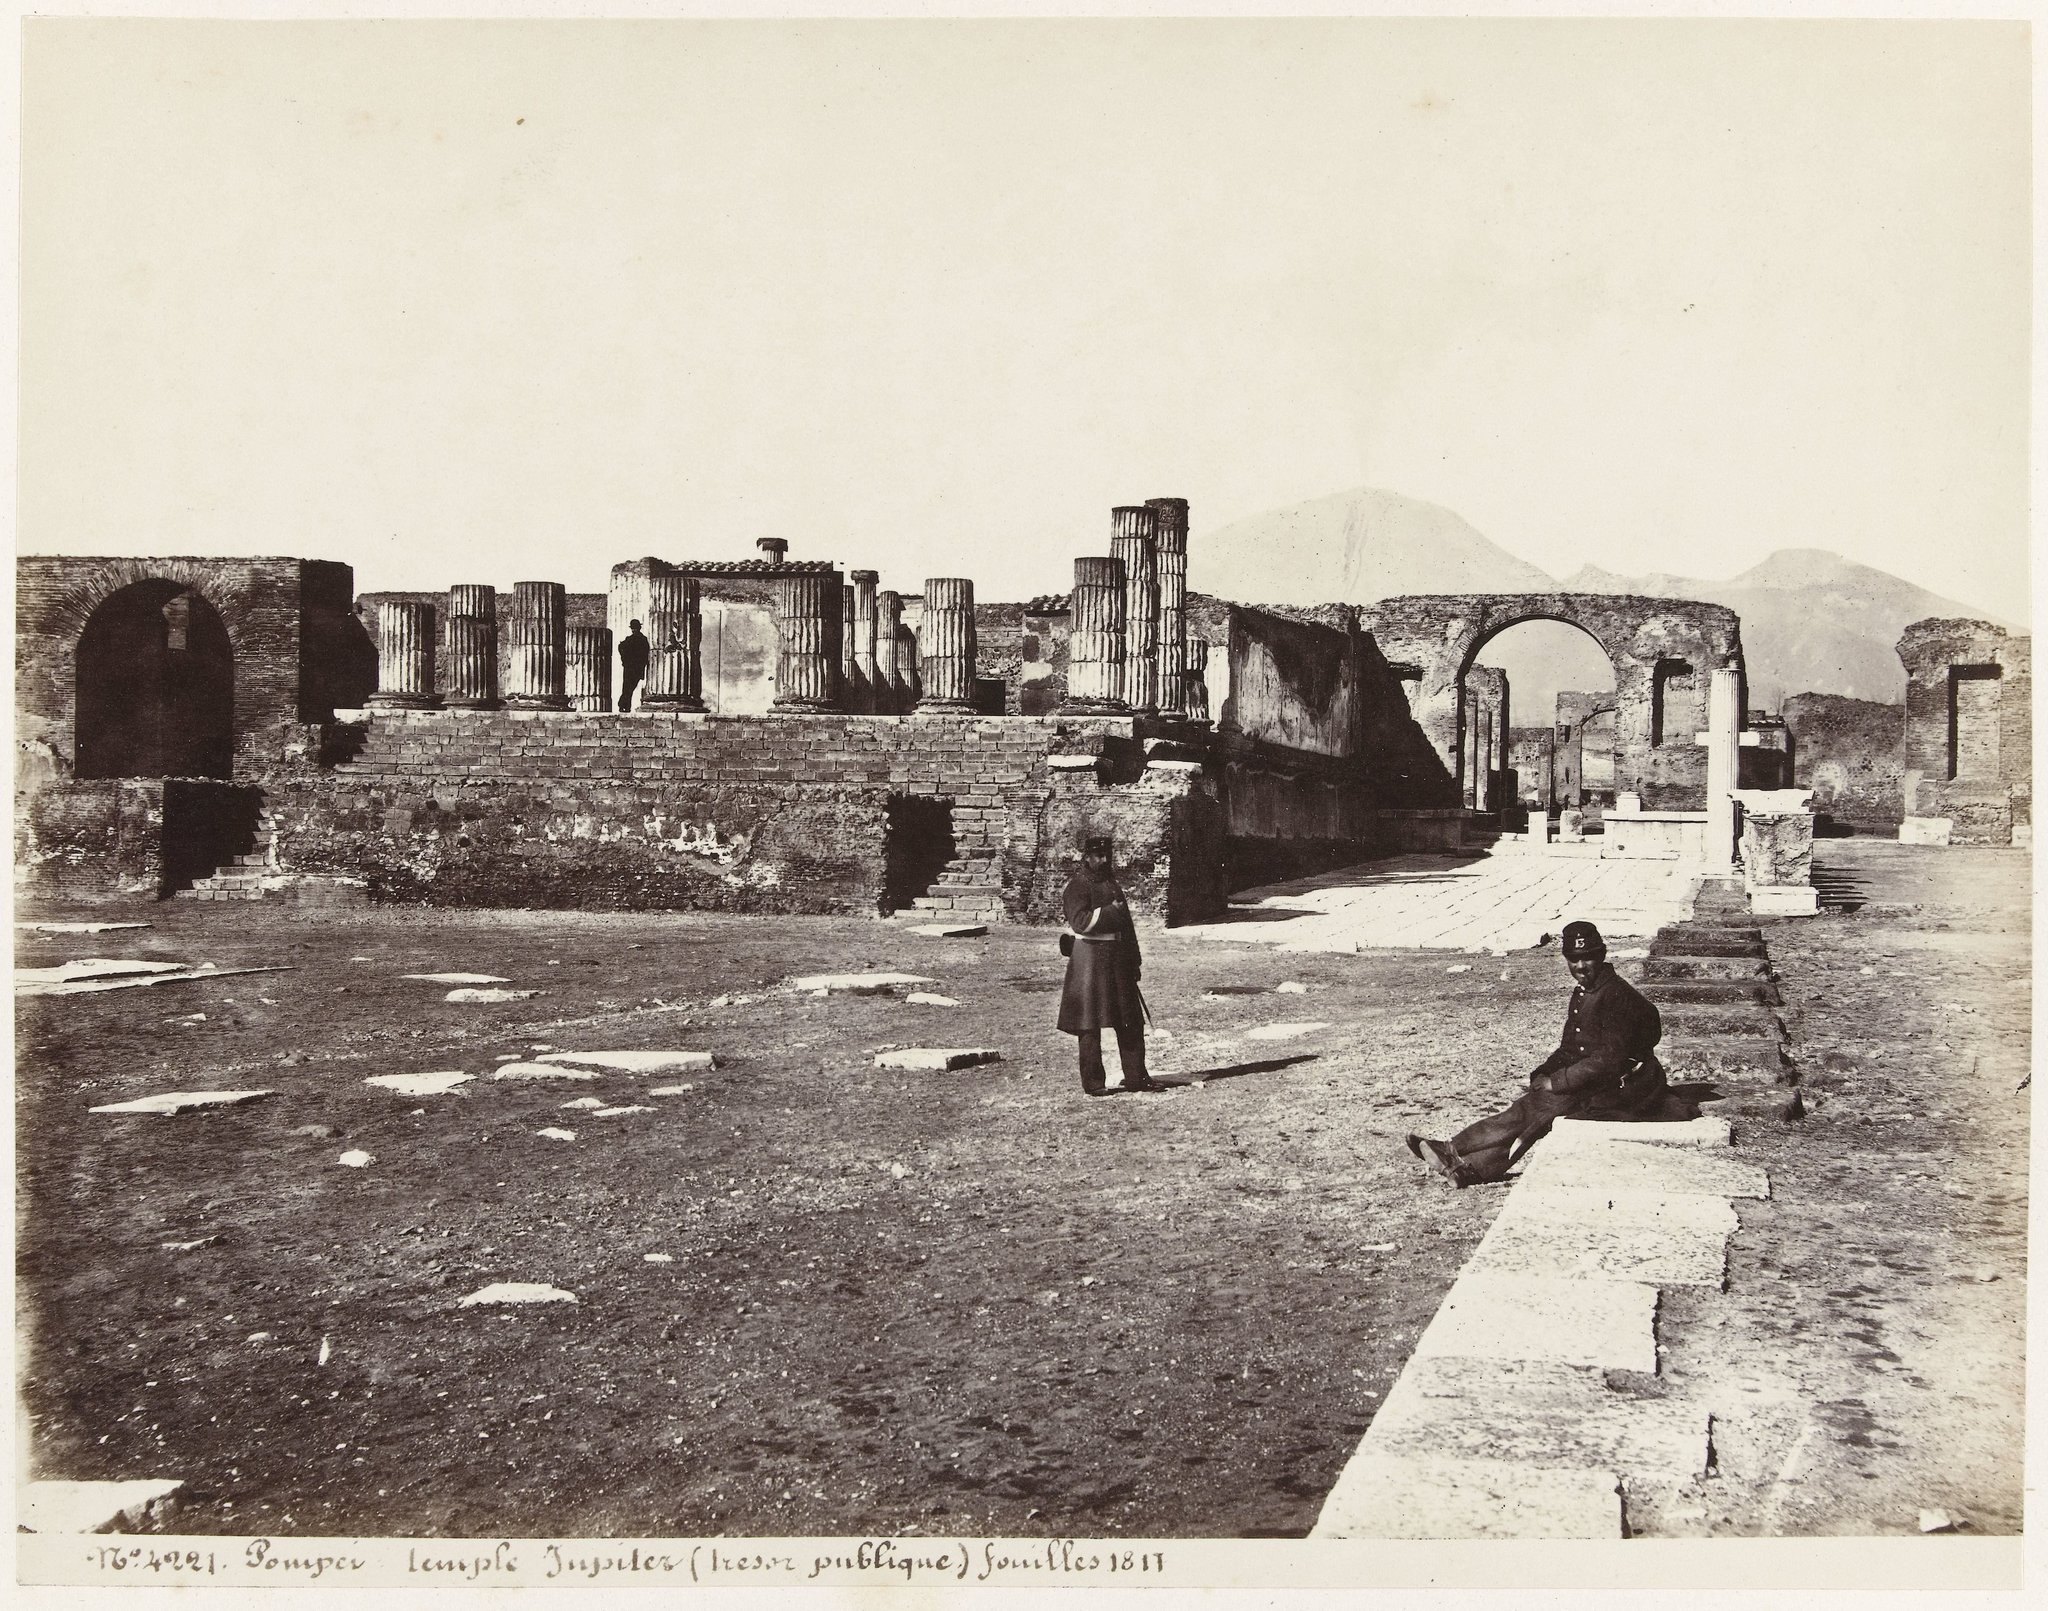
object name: photograph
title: Temple Jupiter (tresor publique) fouilles 1817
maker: Anonymous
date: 1851-1900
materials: cardboard, paper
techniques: albumen print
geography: pompeii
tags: temple, shrine ~ roman religion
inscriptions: number: ‘No. 4221’, number: ‘25’, number: ‘10’